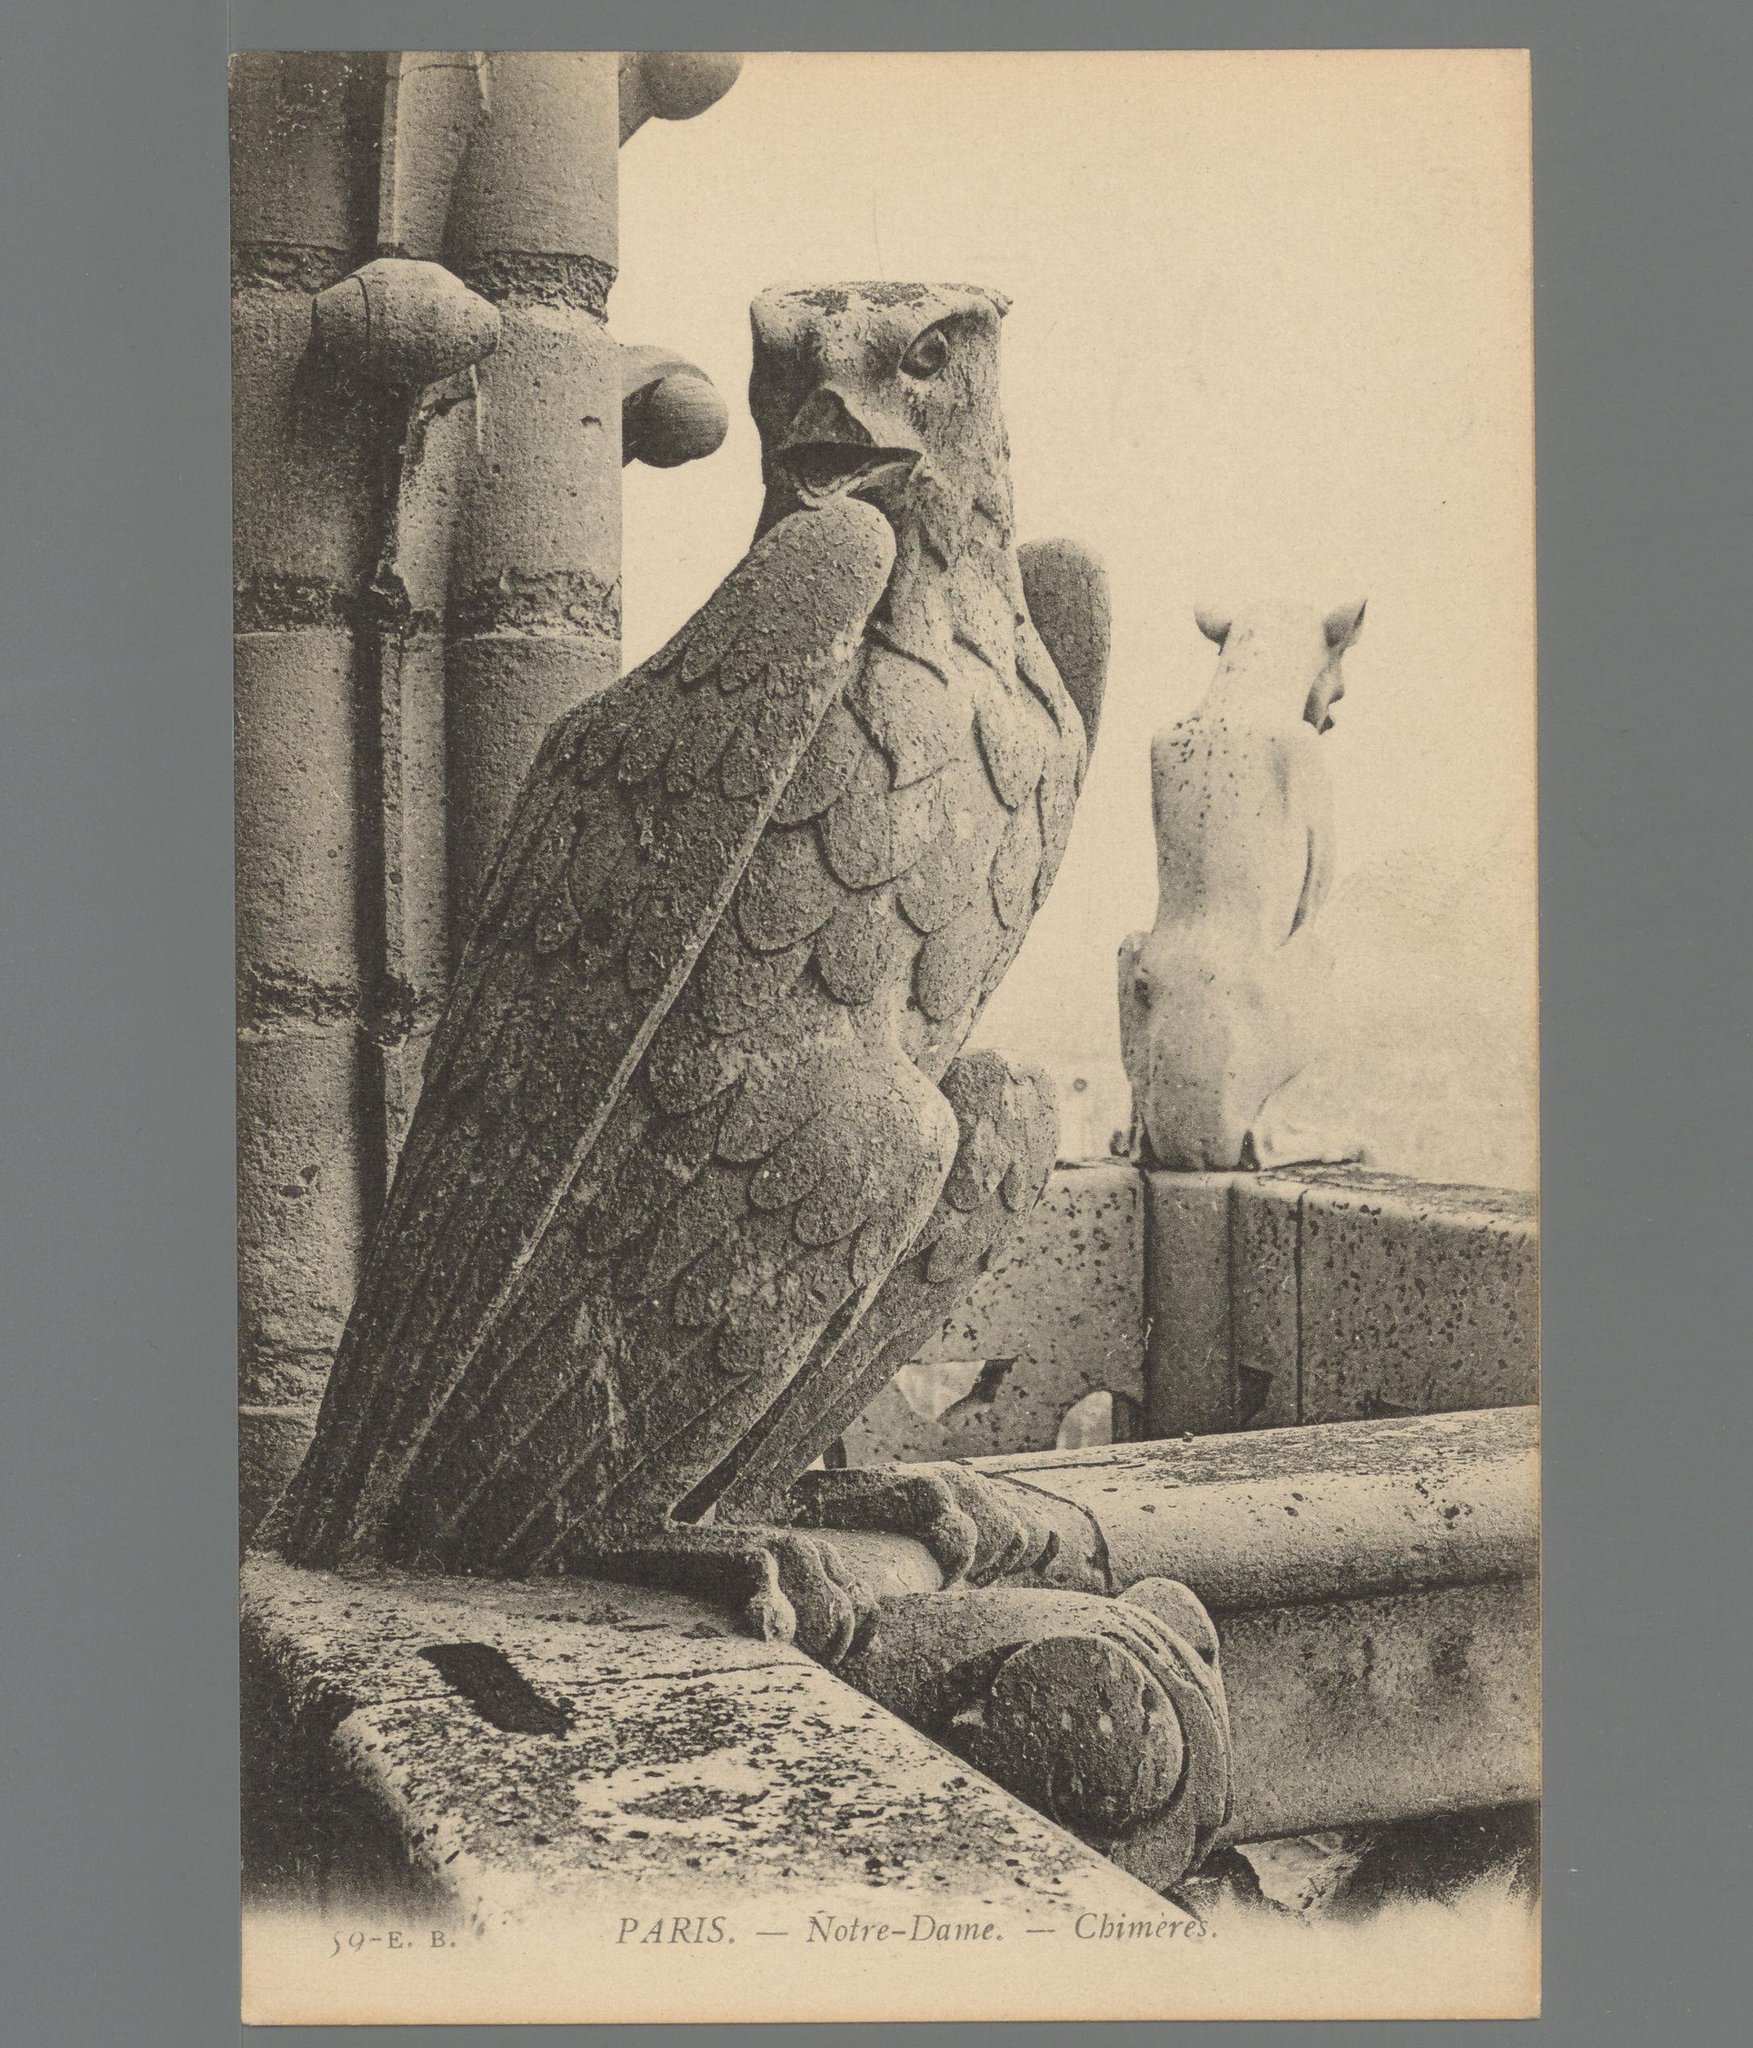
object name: photomechanical print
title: Paris. Notre-Dame. Chimères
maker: Anonymous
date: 1904-1906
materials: cardboard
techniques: photograph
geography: paris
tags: ornament ~ grotesque, church (exterior), sculpture